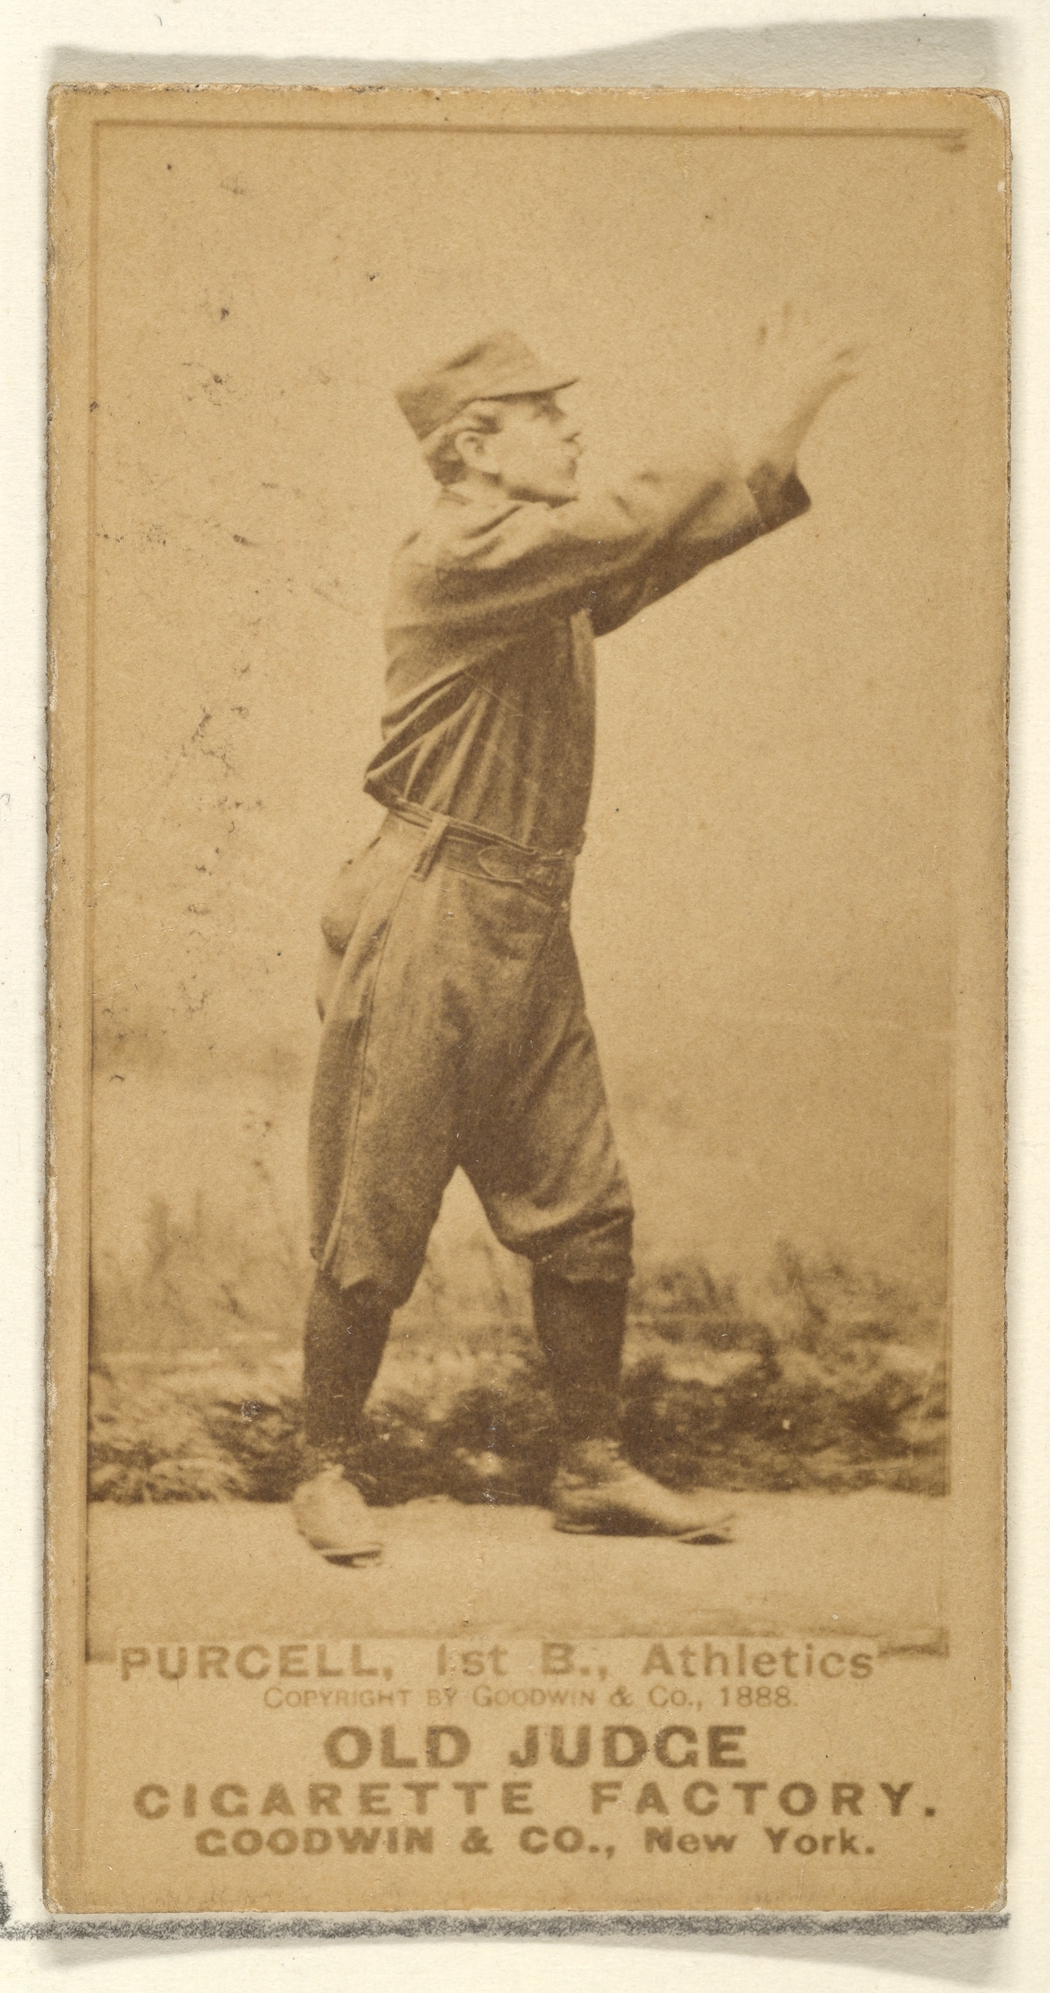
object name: baseball card, photograph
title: Purcell, 1st Base, Philadelphia Athletics, from the Old Judge series (N172) for Old Judge Cigarettes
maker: goodwin & company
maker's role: publisher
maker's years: 1850-1950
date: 1888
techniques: albumen silver print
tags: men,portraits,baseball,athletes